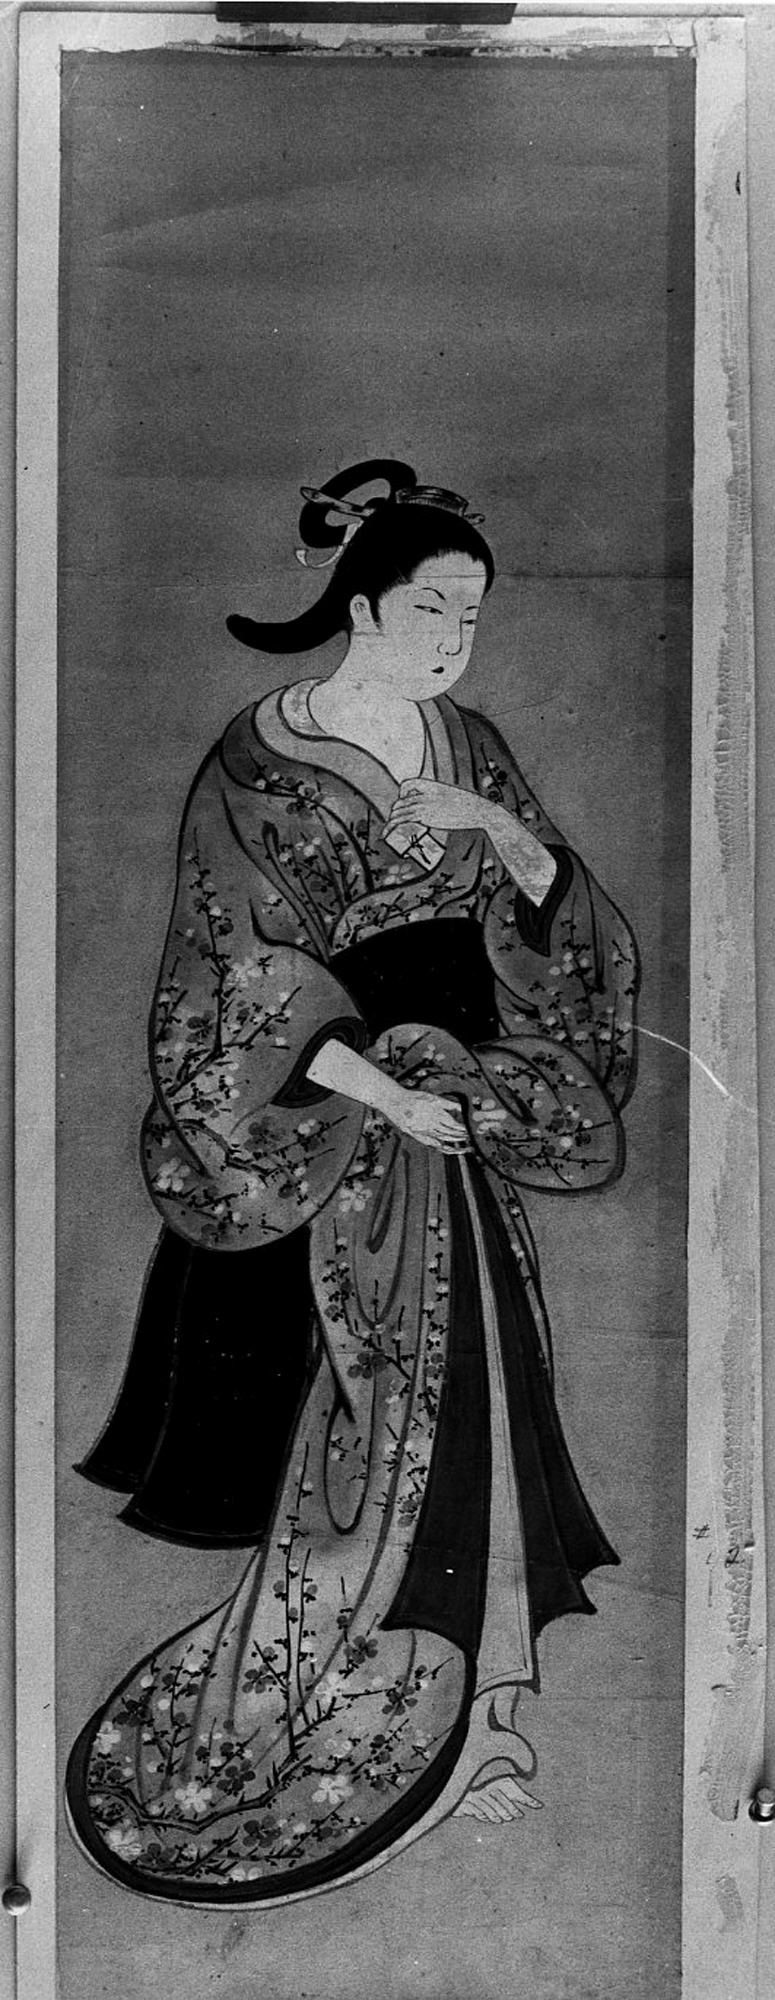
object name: hanging scroll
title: Beauty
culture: japanese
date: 1701-1900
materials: ink, paper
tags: women